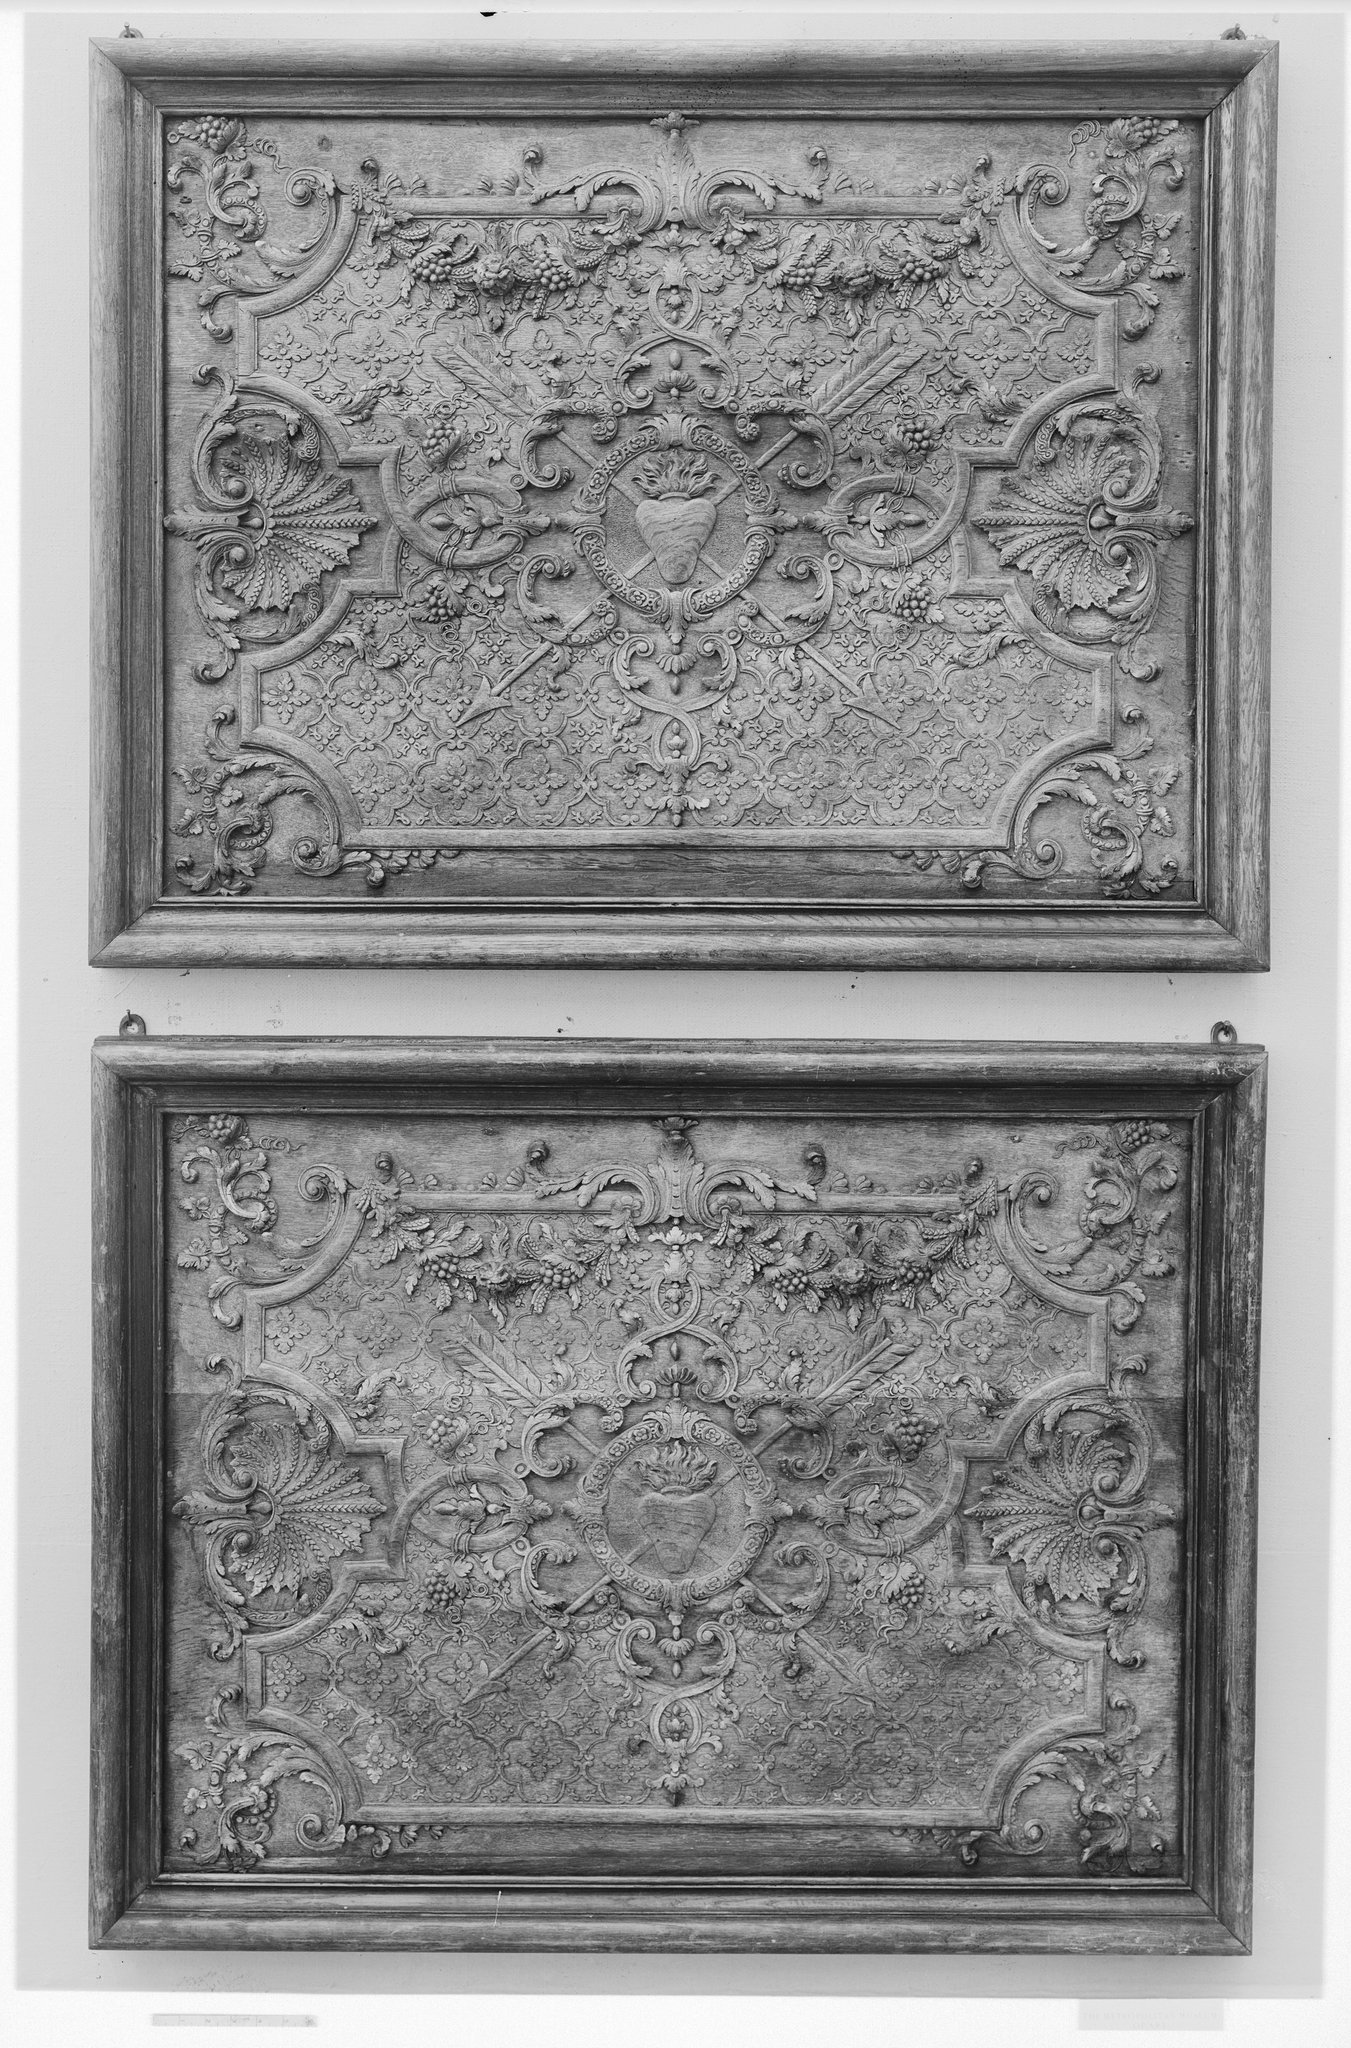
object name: panel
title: Pair of panels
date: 1667-1733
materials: wood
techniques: polish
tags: arrows,leaves